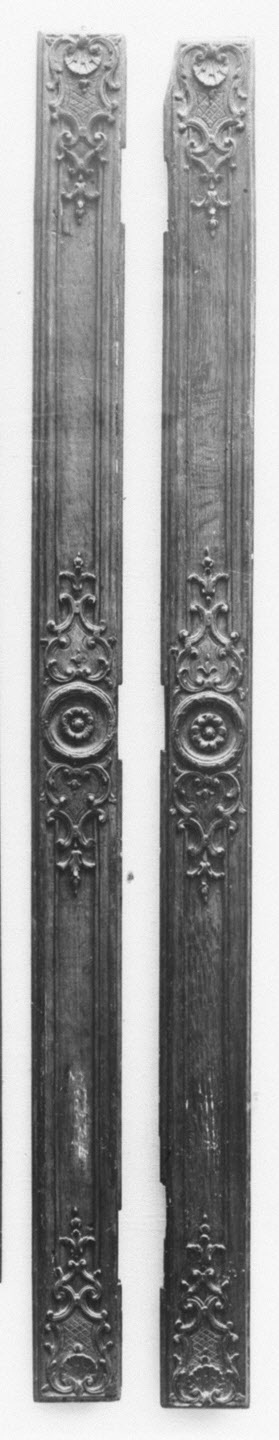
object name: armoire pilaster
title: Pair of pilasters from an armoire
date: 1667-1733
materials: wood